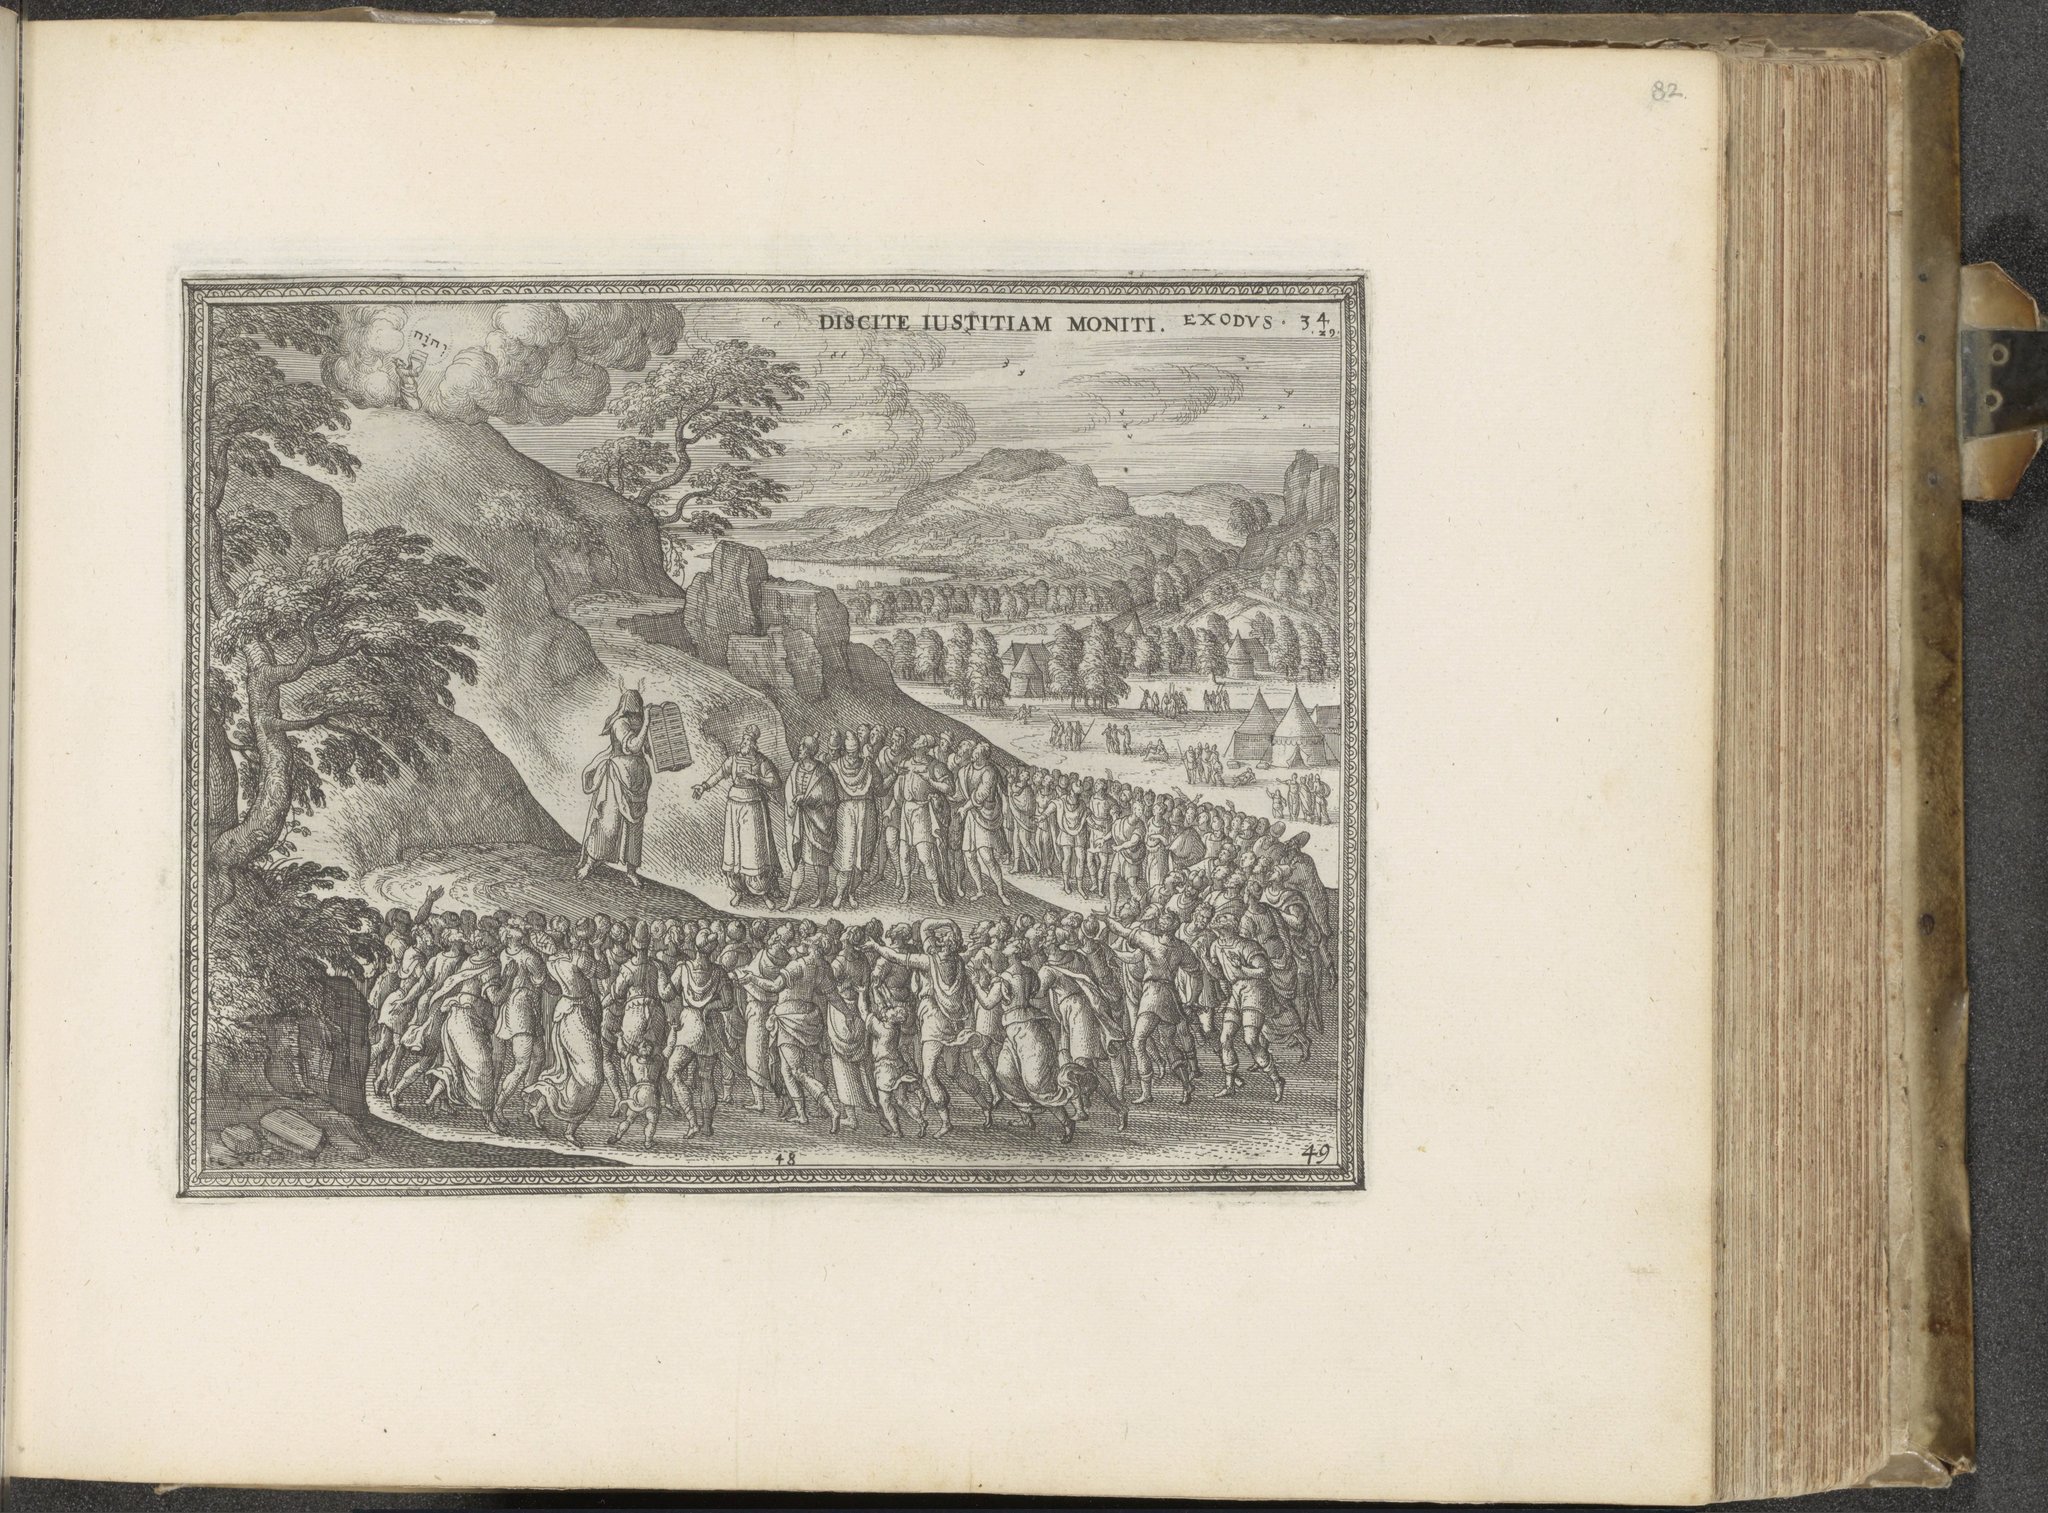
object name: print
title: Imagines et figurae bibliorum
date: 1582-1593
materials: paper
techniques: etching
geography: amsterdam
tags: tetragram (in roman or hebrew script) ~ symbol of god the father, old testament, the new tables of the law (exodus 34), moses covers his face with a veil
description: Linksboven op de berg Sinaï ontvangt Mozes de tafelen der wet. Het tetragram staat symbool voor God de Vader. Onderaan de berg toont Mozes de tafelen aan het volk. Zijn gezicht is bedekt met een doek (Ex. 34:29). De prent maakt deel uit van een album.